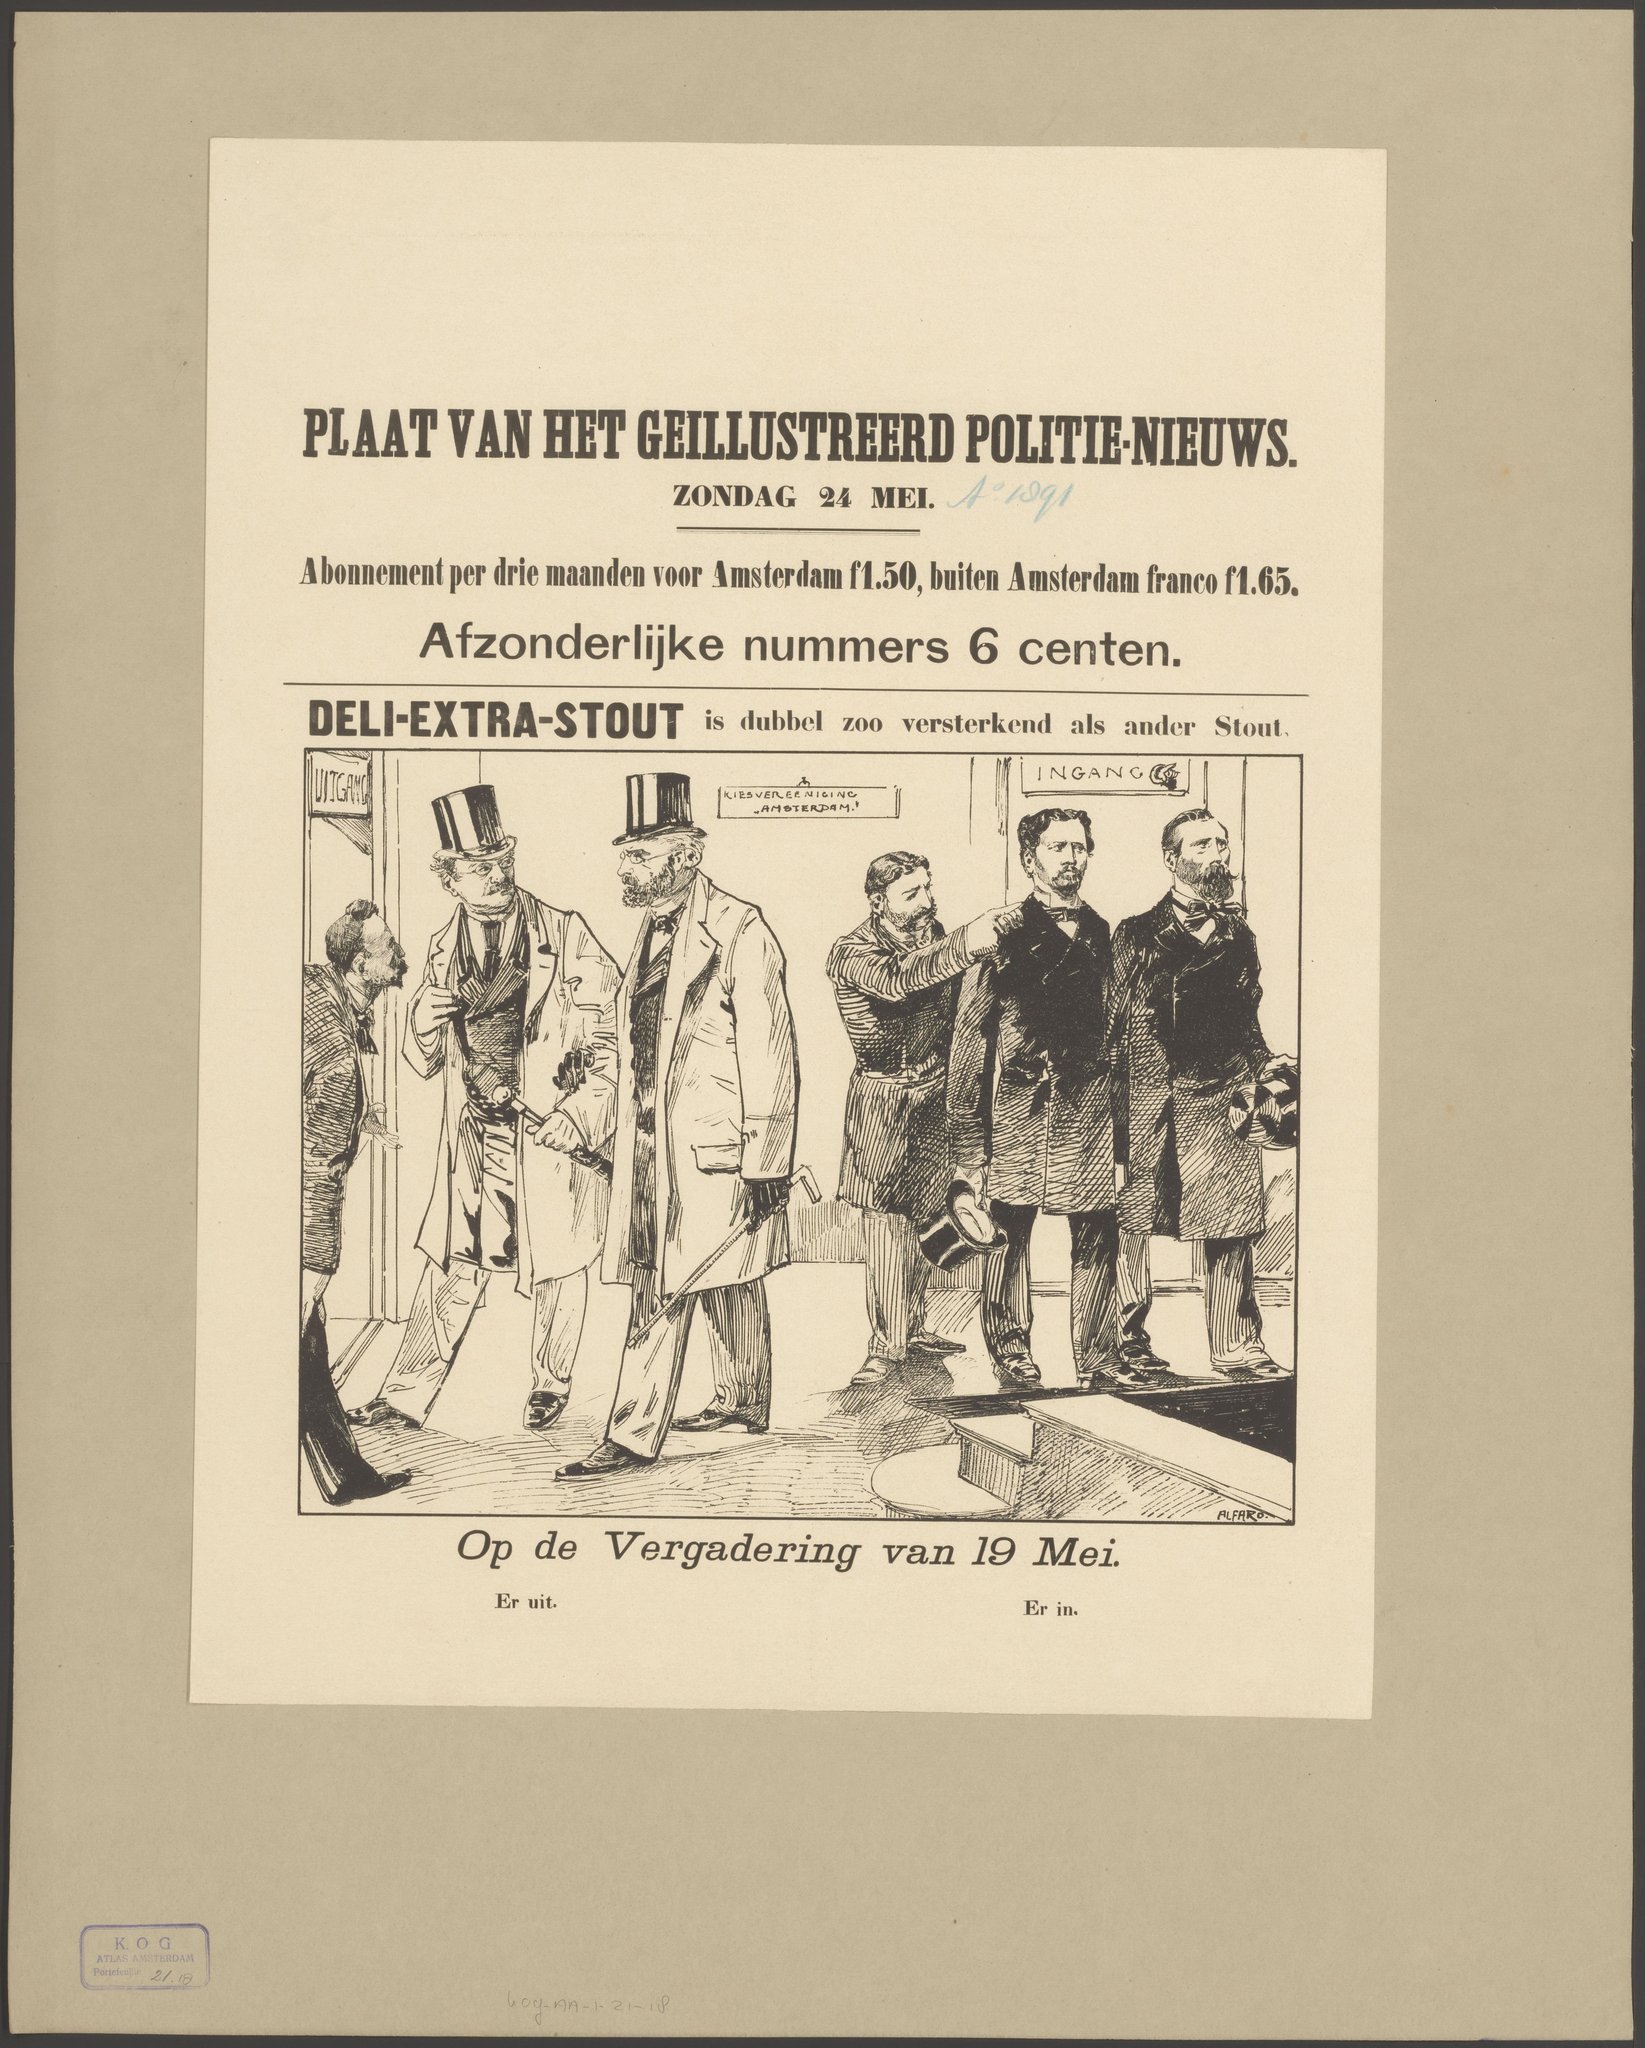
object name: cartoon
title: Op de Vergadering van 19 Mei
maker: alfaro reijding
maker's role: draughtsman, engineer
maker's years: 1863-1930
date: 1891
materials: paper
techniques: letterpress printing, lithograph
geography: amsterdam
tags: political caricatures and satires, amsterdam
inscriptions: collector's mark: Lugt 1641b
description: Onderwerpsrubriek binnen de Atlas Amsterdam: Kiesverenigingen, Politieke partijen.